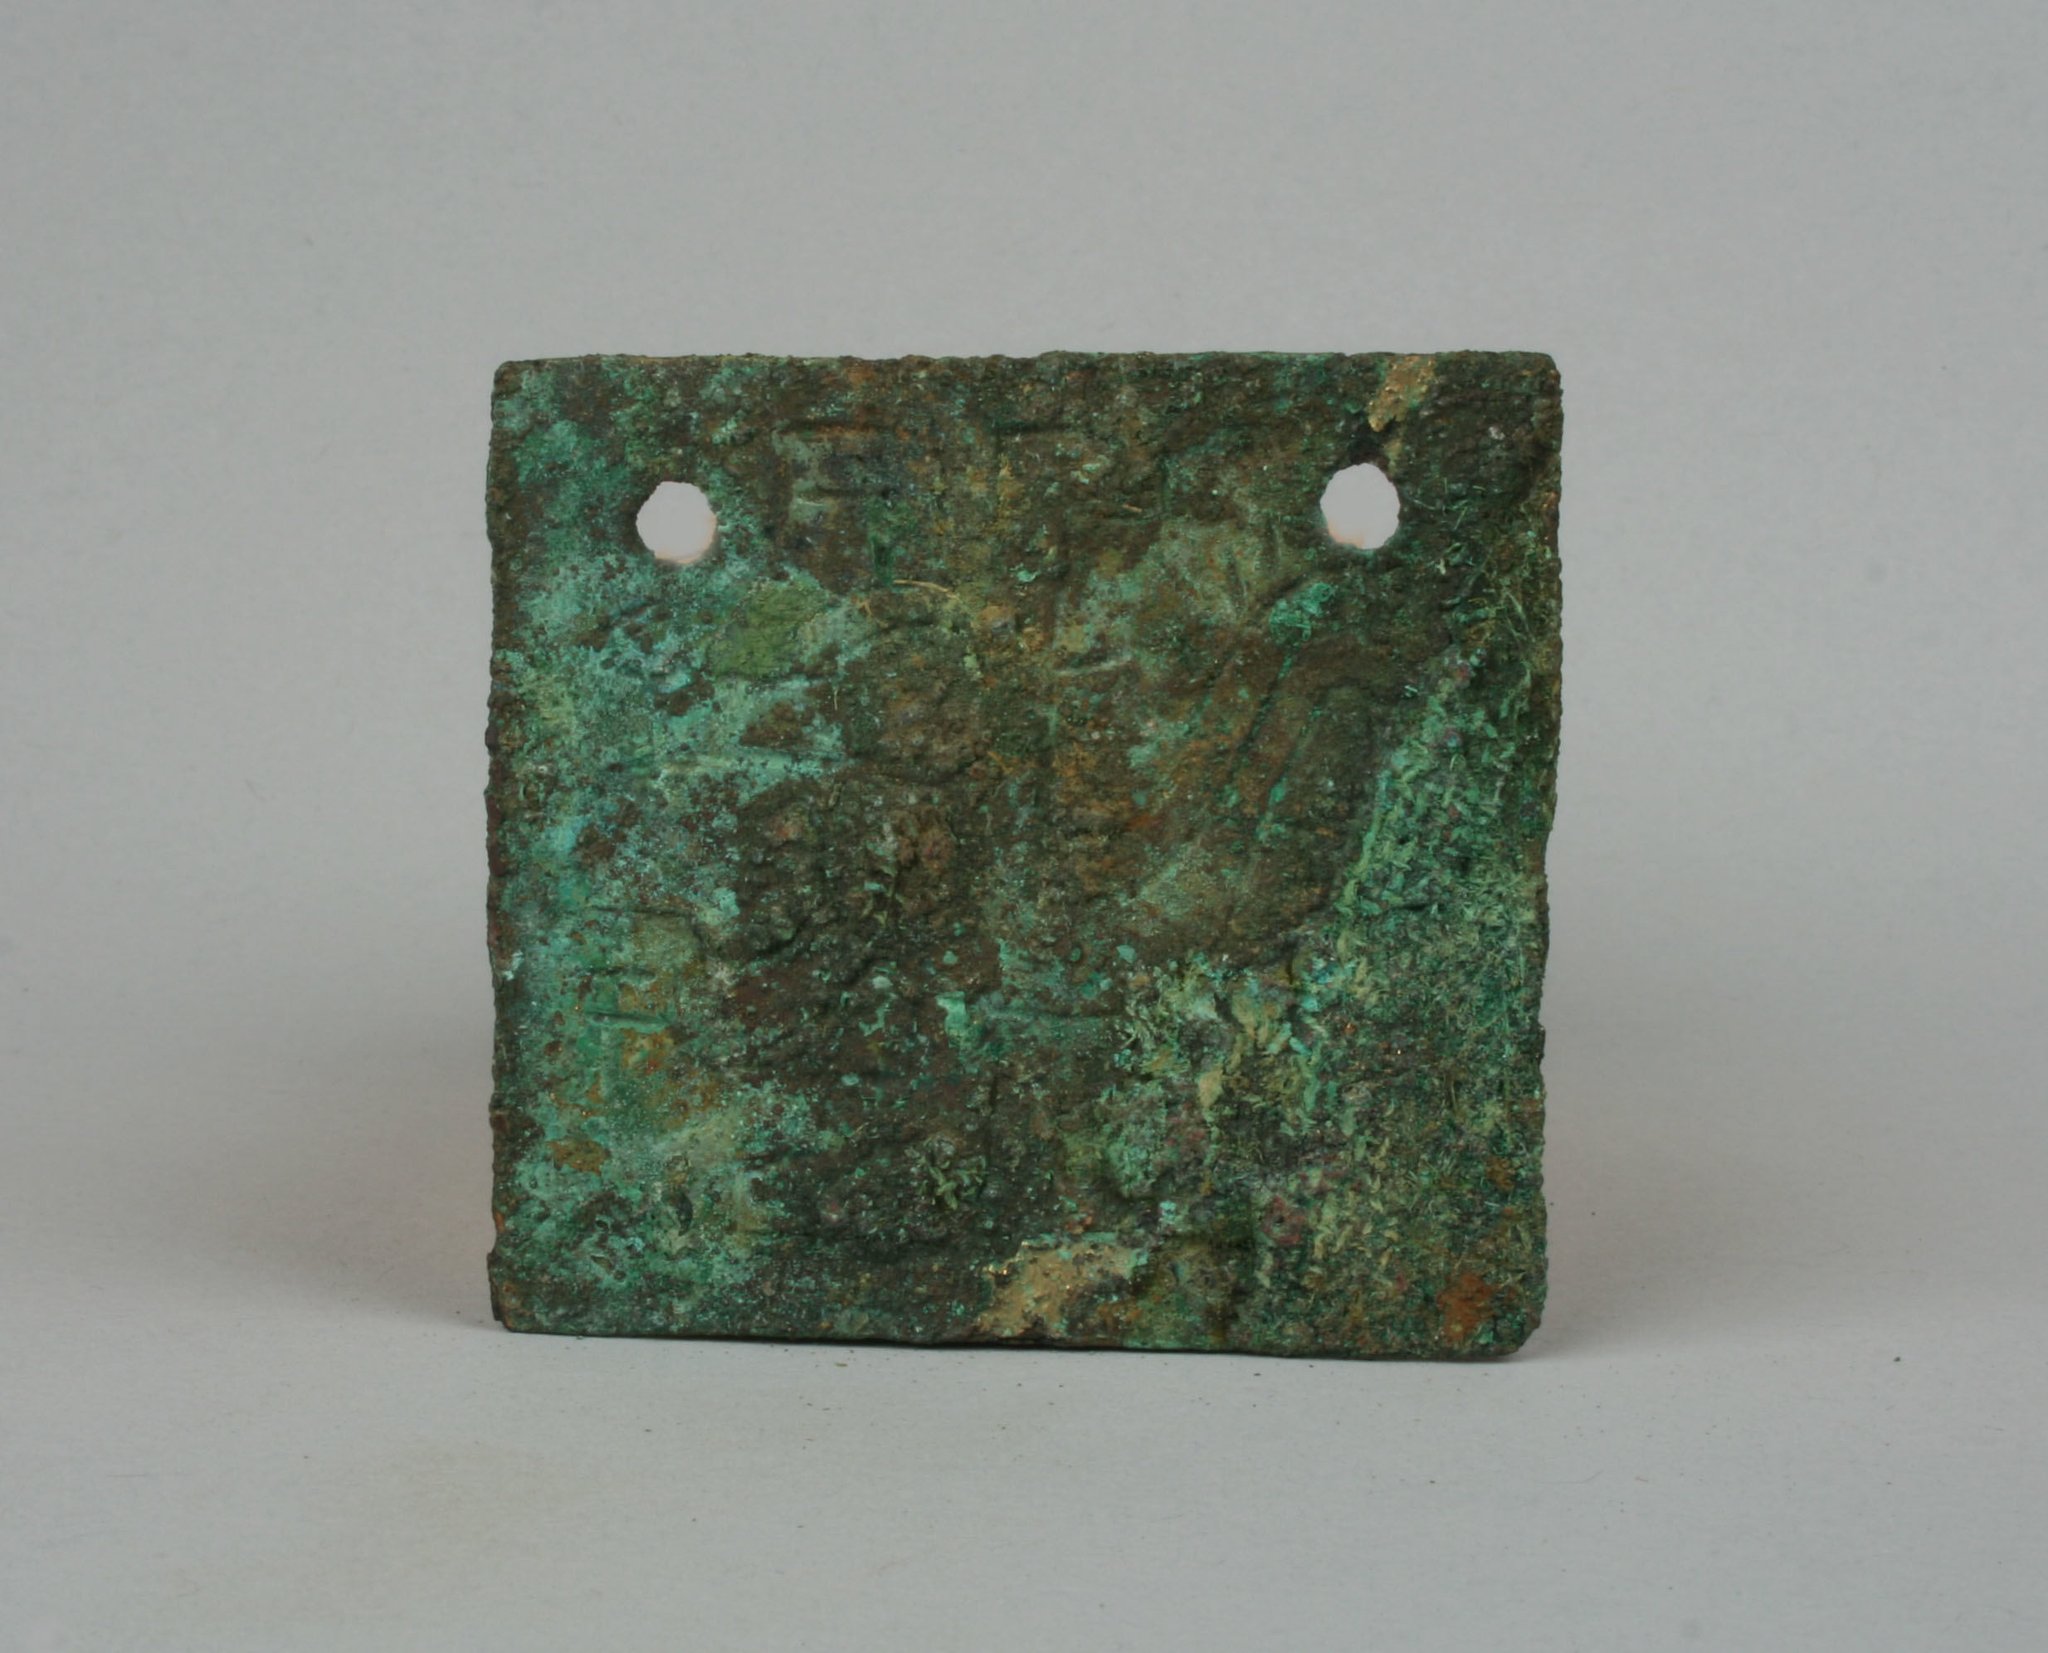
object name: ornament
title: Bird Plaque Ornament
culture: vicús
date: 300 BCE-200 CE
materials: copper, gilt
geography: peru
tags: birds